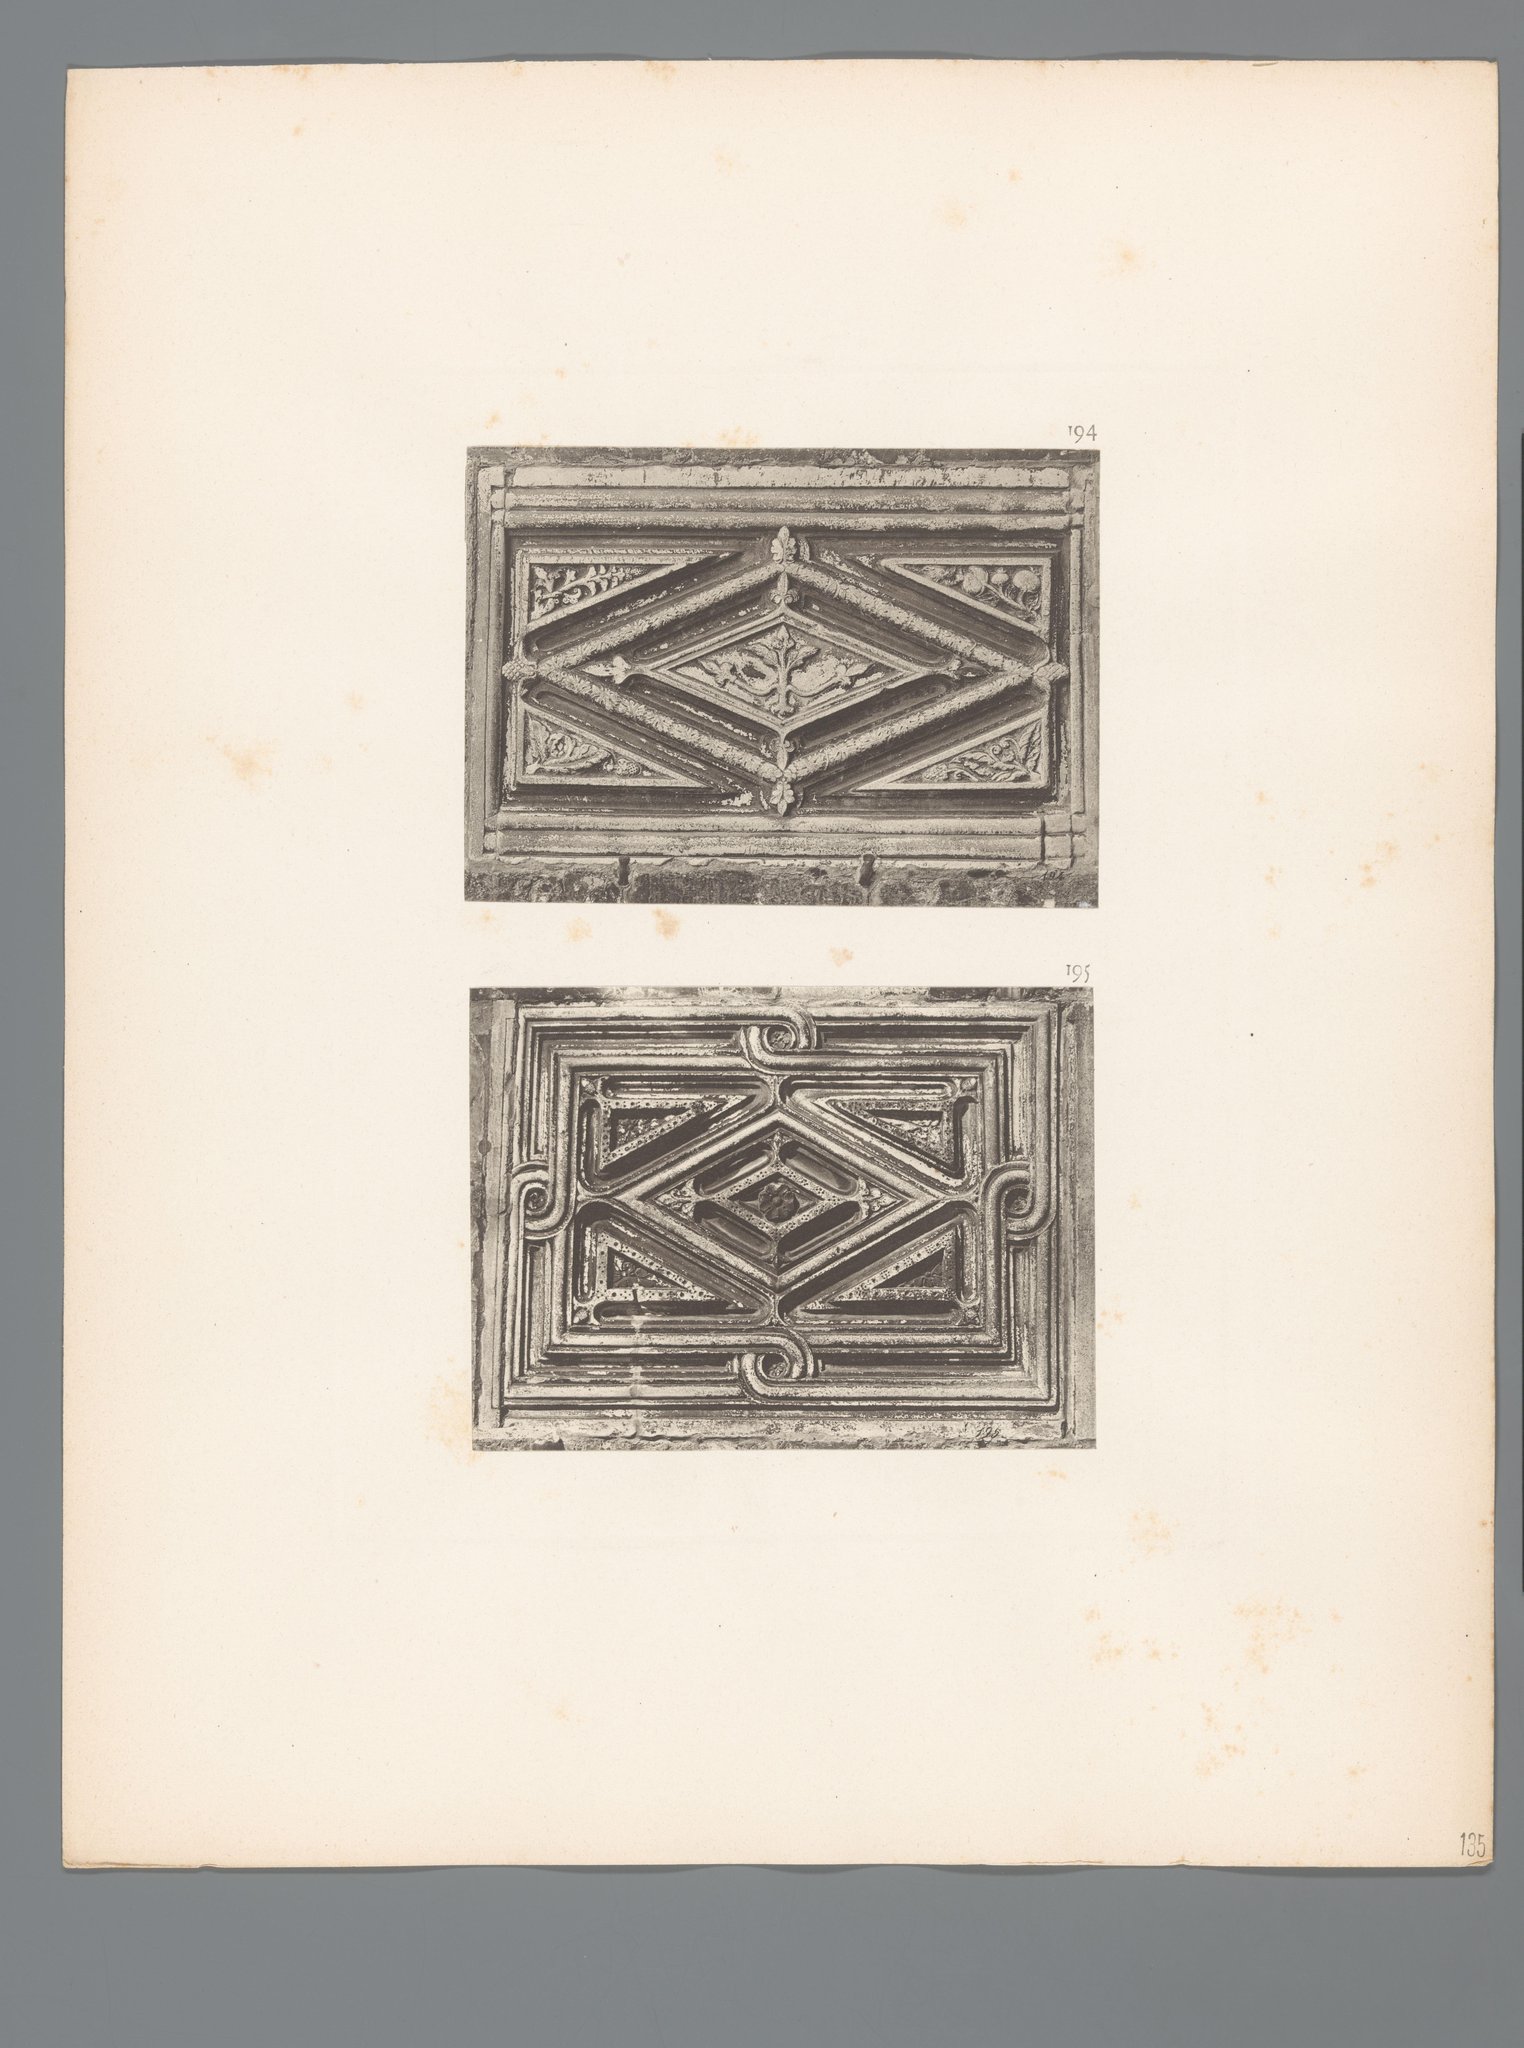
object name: photomechanical print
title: Twee details van het exterieur van de San Marco in Venetië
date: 1879-1884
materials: paper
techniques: photograph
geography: venice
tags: church (exterior), piece of sculpture, reproduction of a piece of sculpture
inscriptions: number: ‘195’, number: ‘135’, number: ‘194’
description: Deze prenten maken deel uit van een omslag met 51 prenten op 29 bladen en 1 tekstblad.